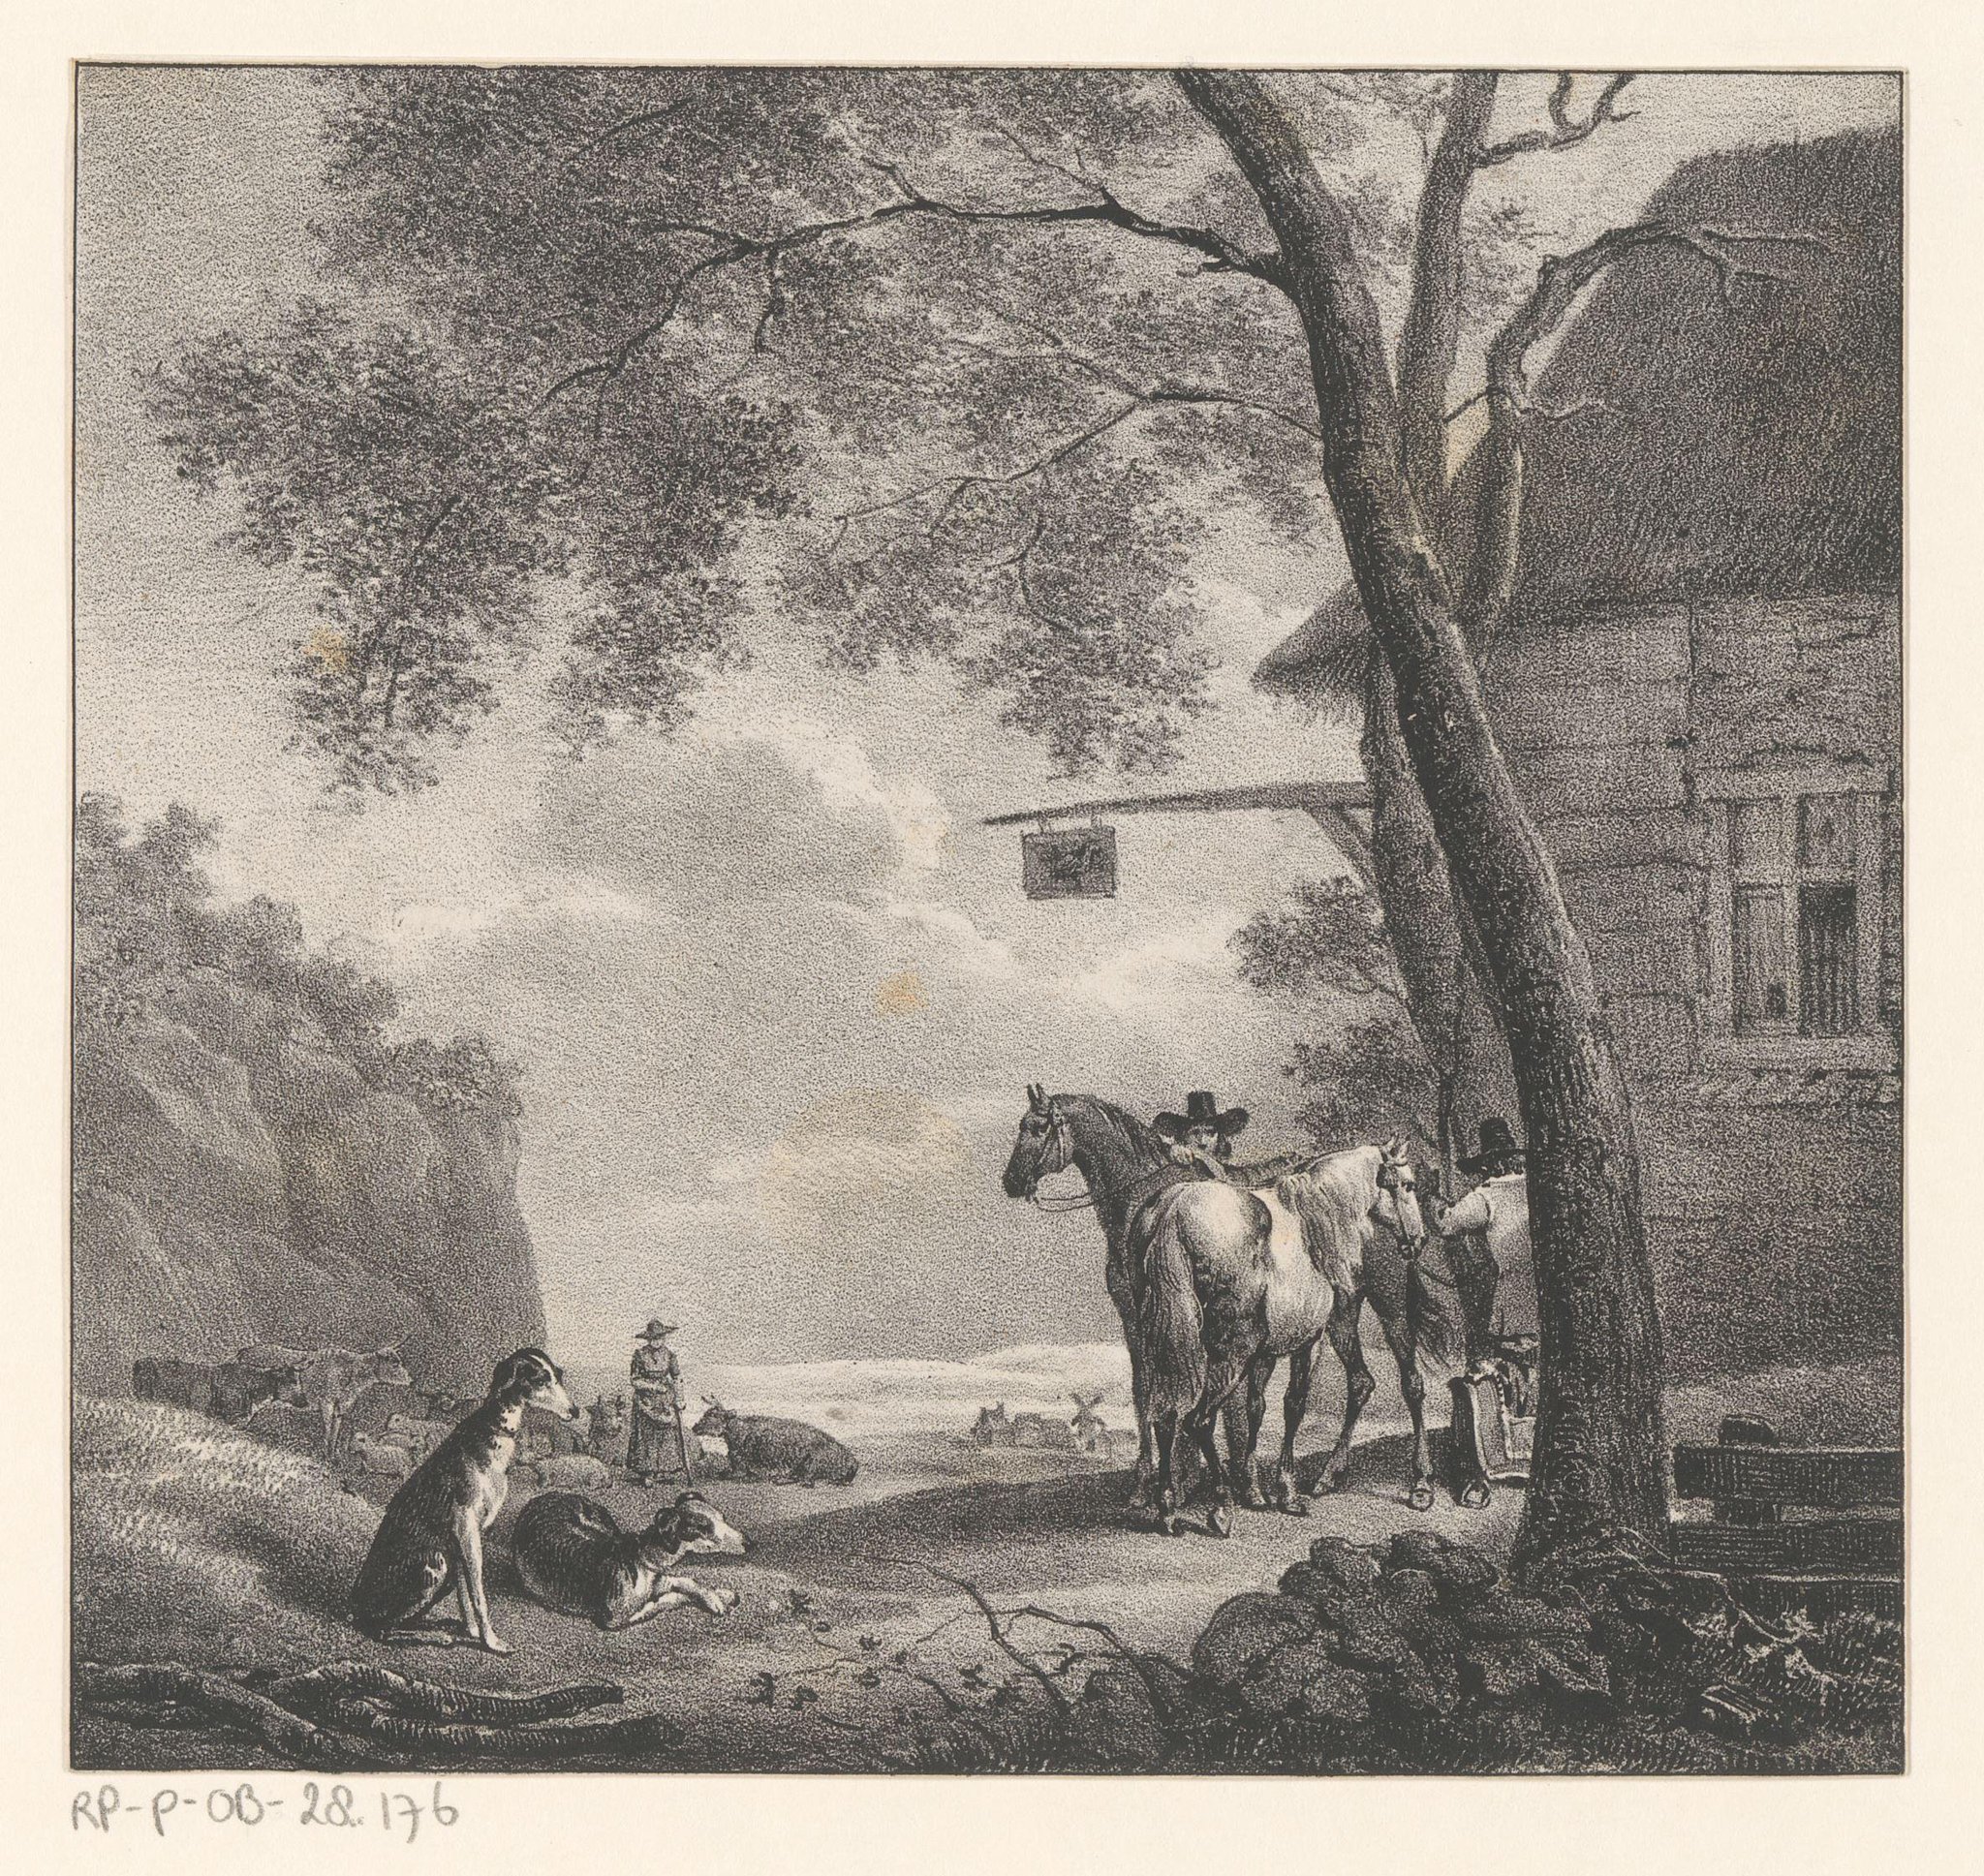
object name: print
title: Twee ruiters bij een herberg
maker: Anonymous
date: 1809-1899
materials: paper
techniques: lithograph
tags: herding, herdsman, herdswoman, shepherd, shepherdess, cowherd, etc., horse (+ departure and arrival ~ traffic and transport), hotel, hostelry, inn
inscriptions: collector's mark: Lugt 2228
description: De ruiters staan bij hun paarden. Links van hen twee honden. In het weiland staat een herder bij zijn kudde.